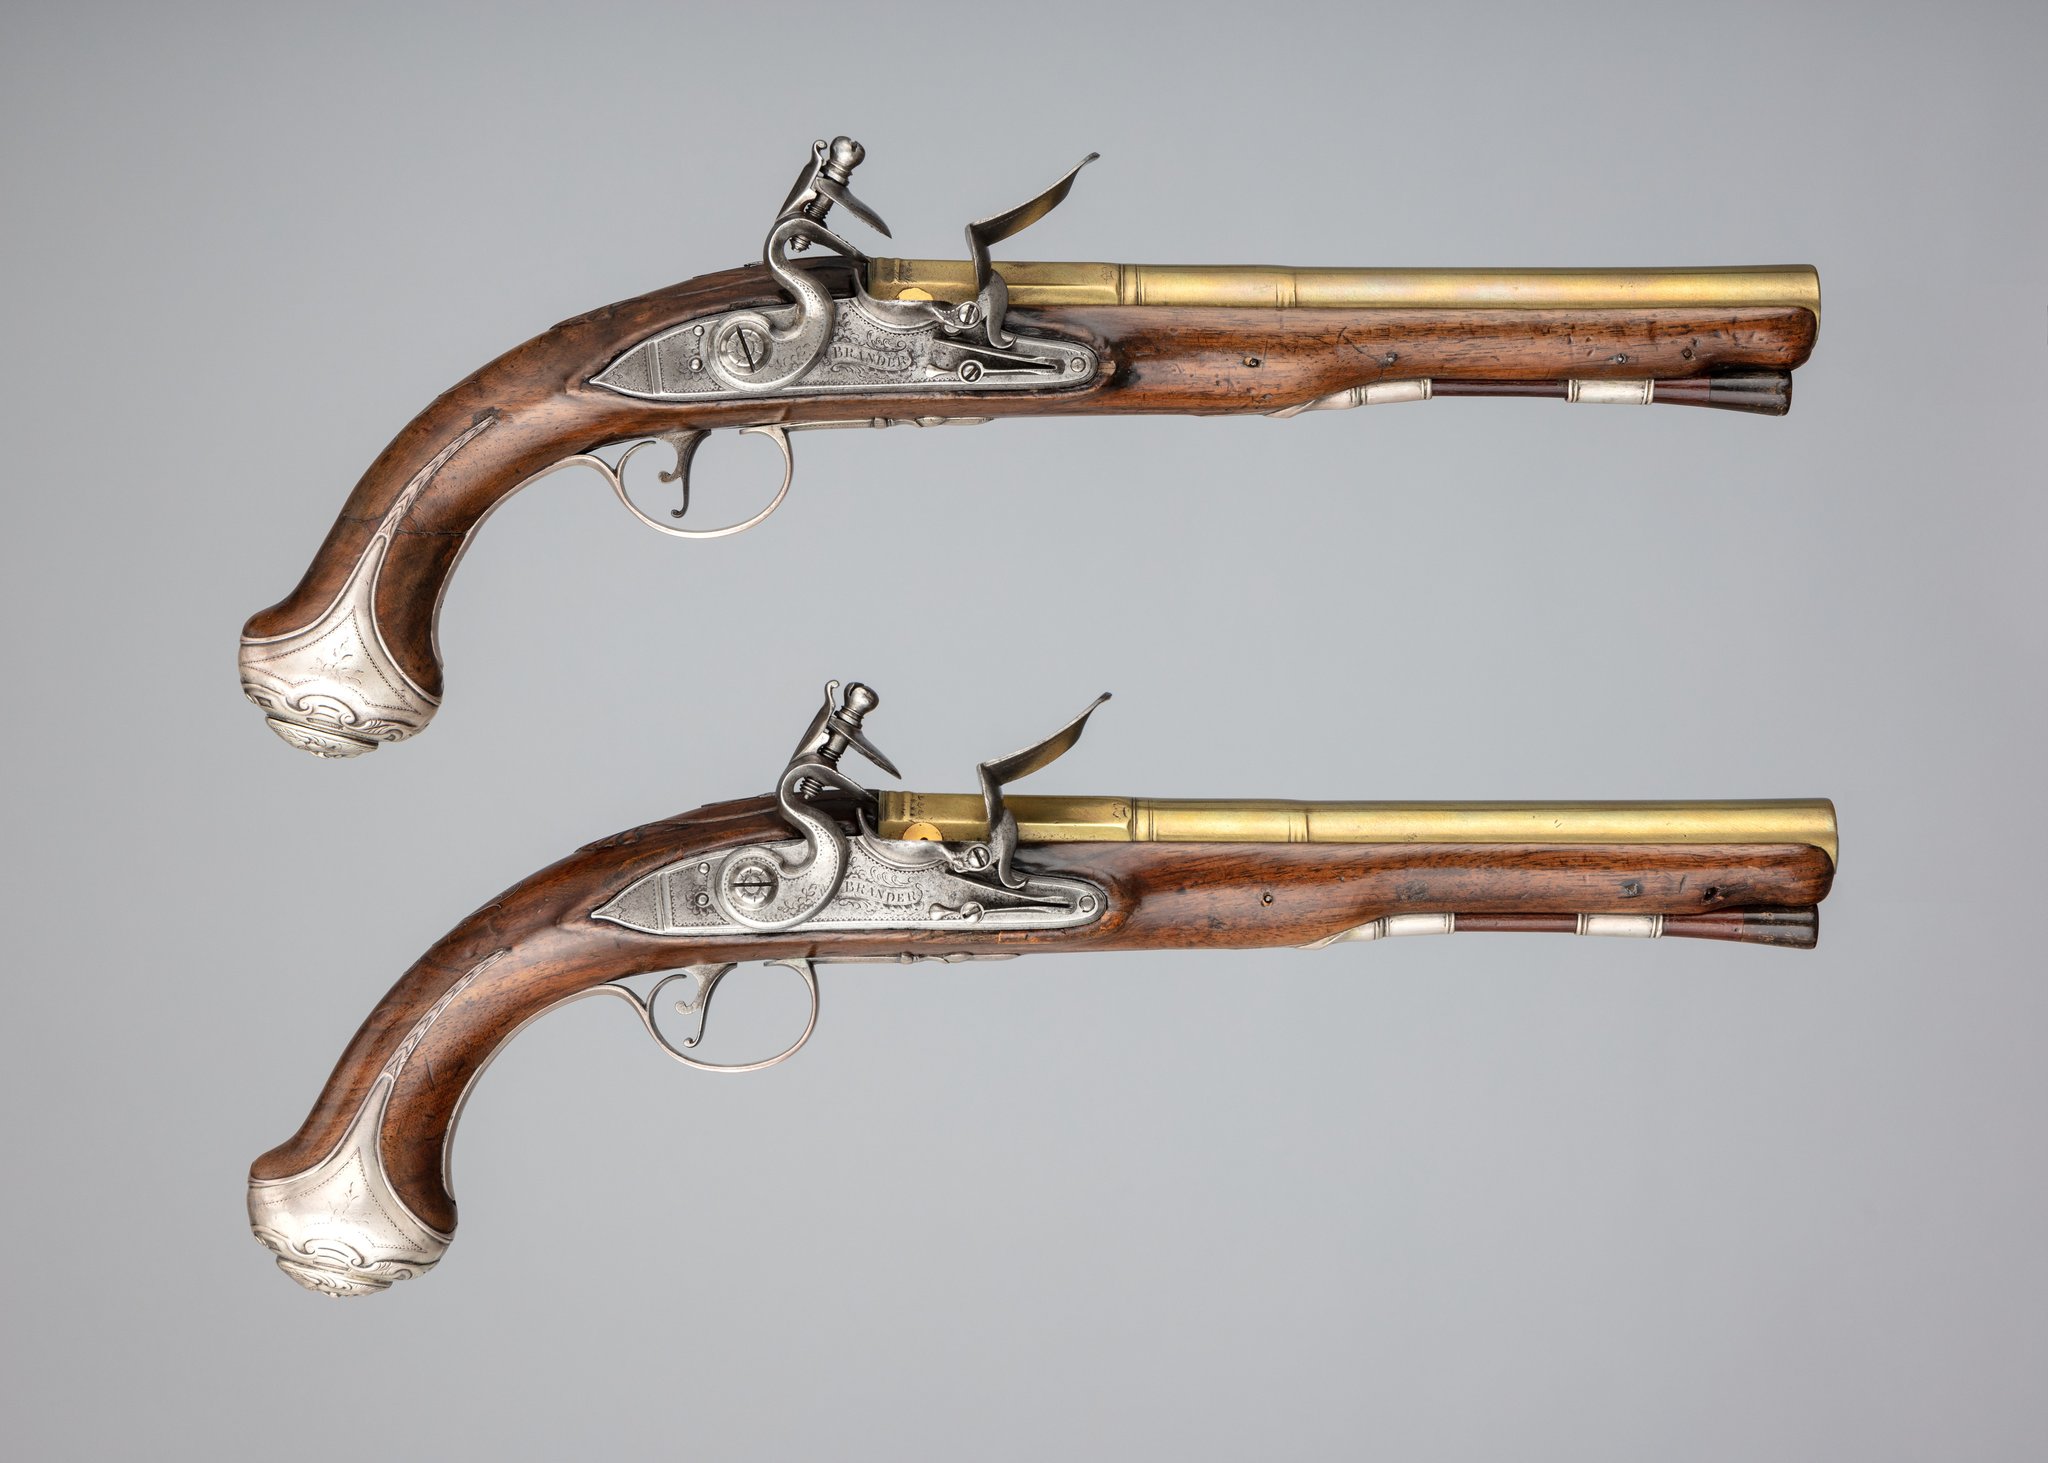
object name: pair of flintlock pistol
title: Pair of Flintlock Pistols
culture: british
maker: william brander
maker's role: gunsmith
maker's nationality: british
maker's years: 1720-1790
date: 1782-1783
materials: brass, gold, horn, silver, steel, wood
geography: britain